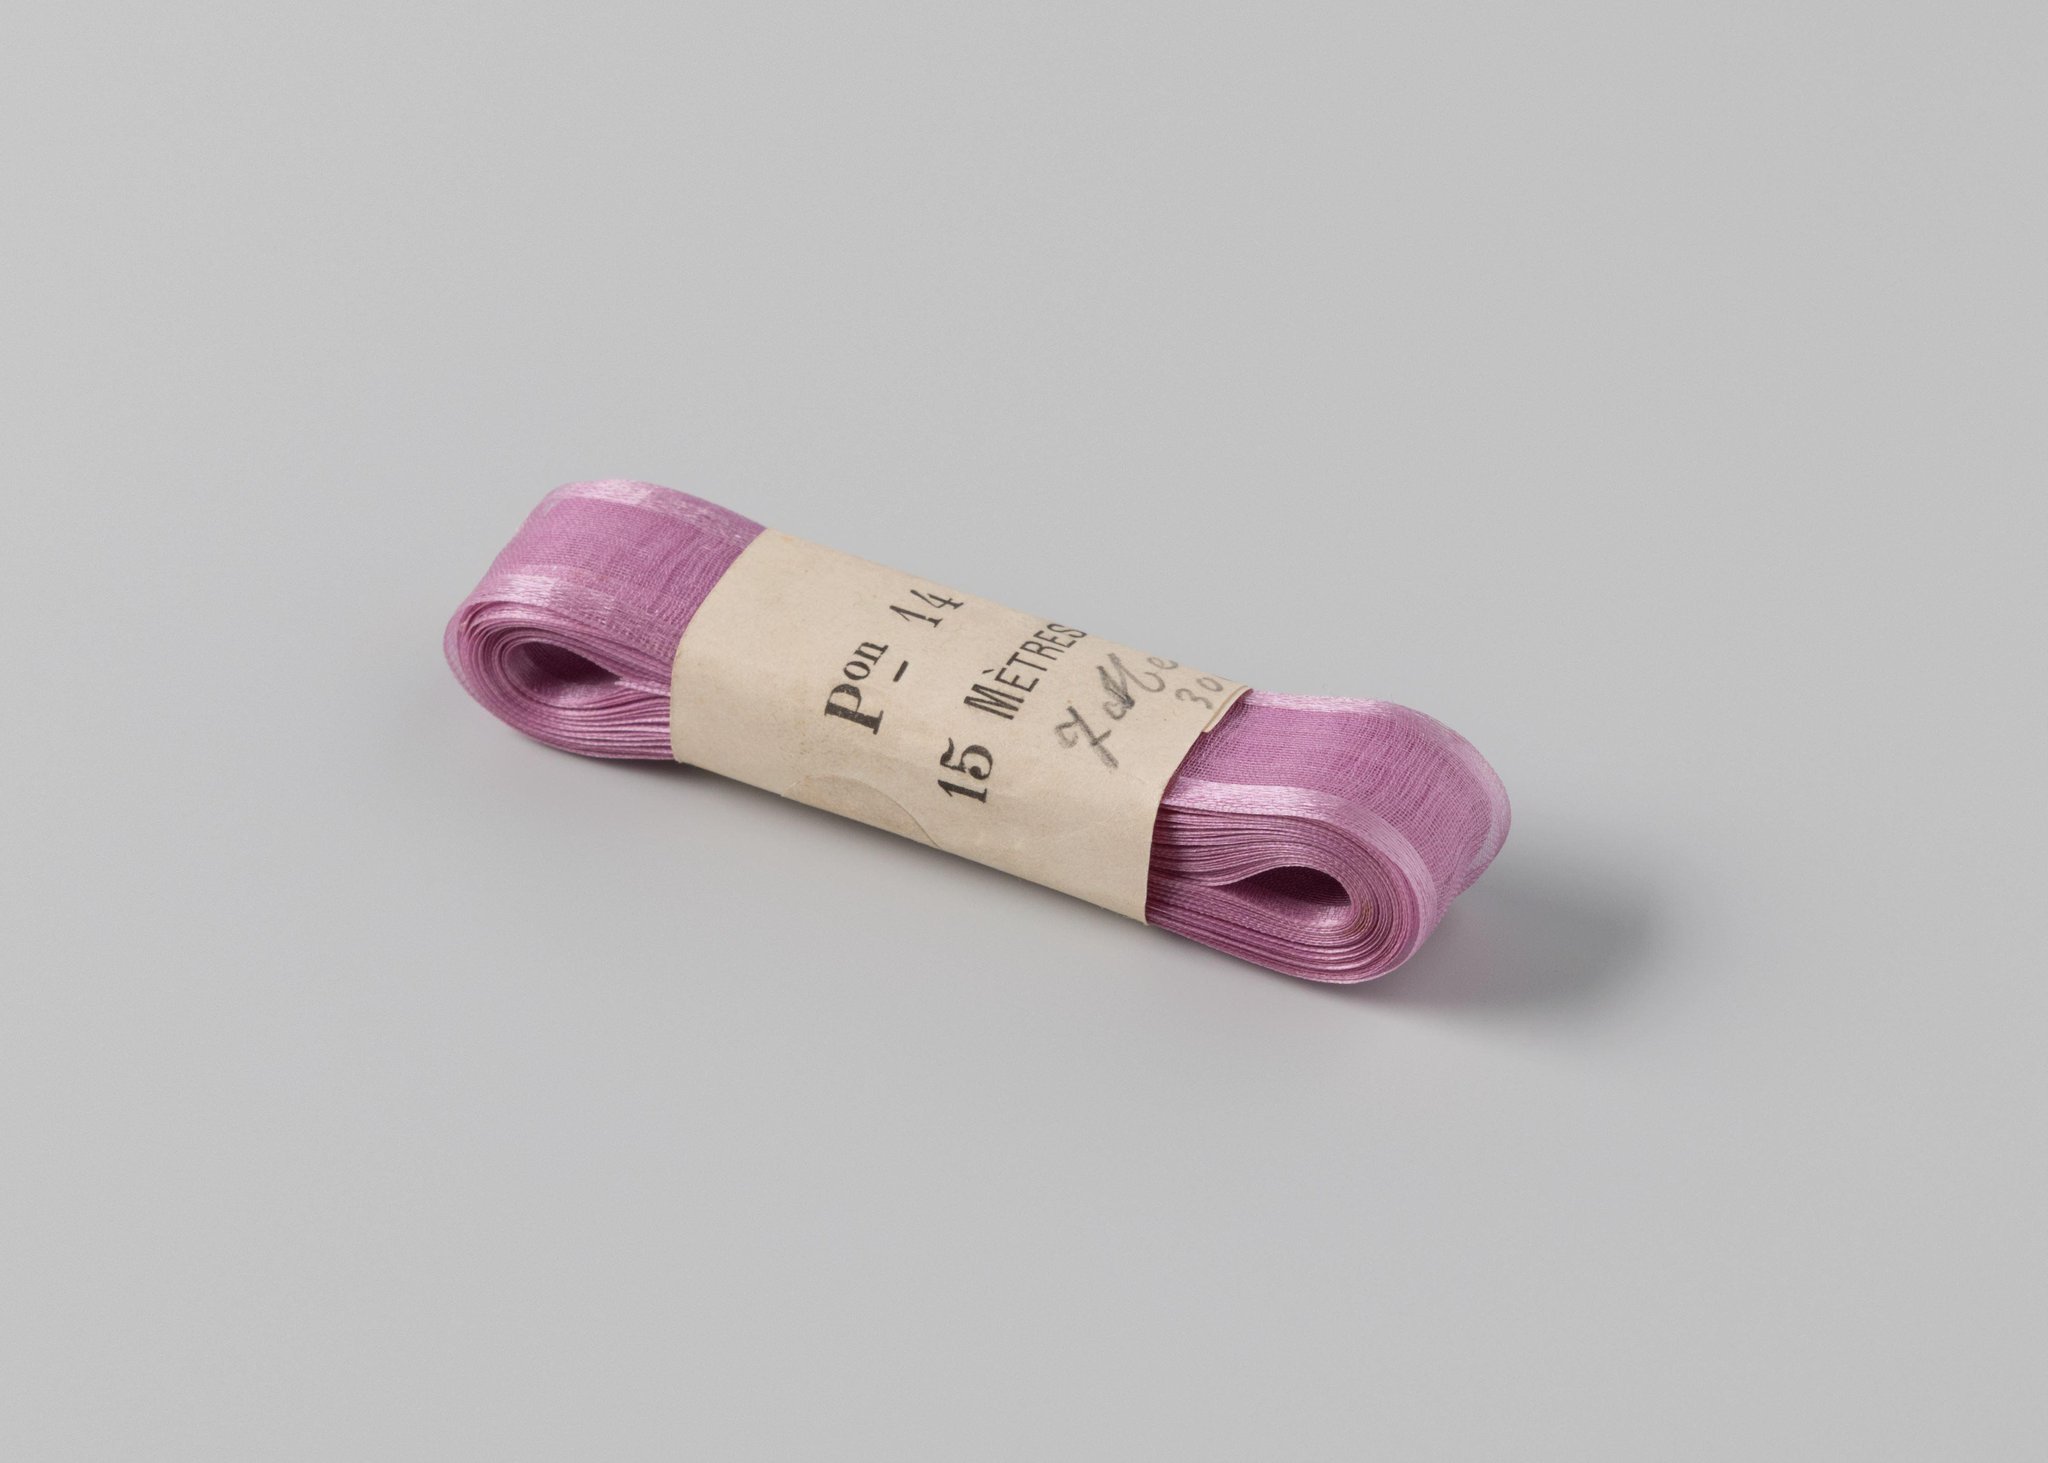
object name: braid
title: Lint van lila gaas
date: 1900-1915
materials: textile, silk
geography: nijmegen